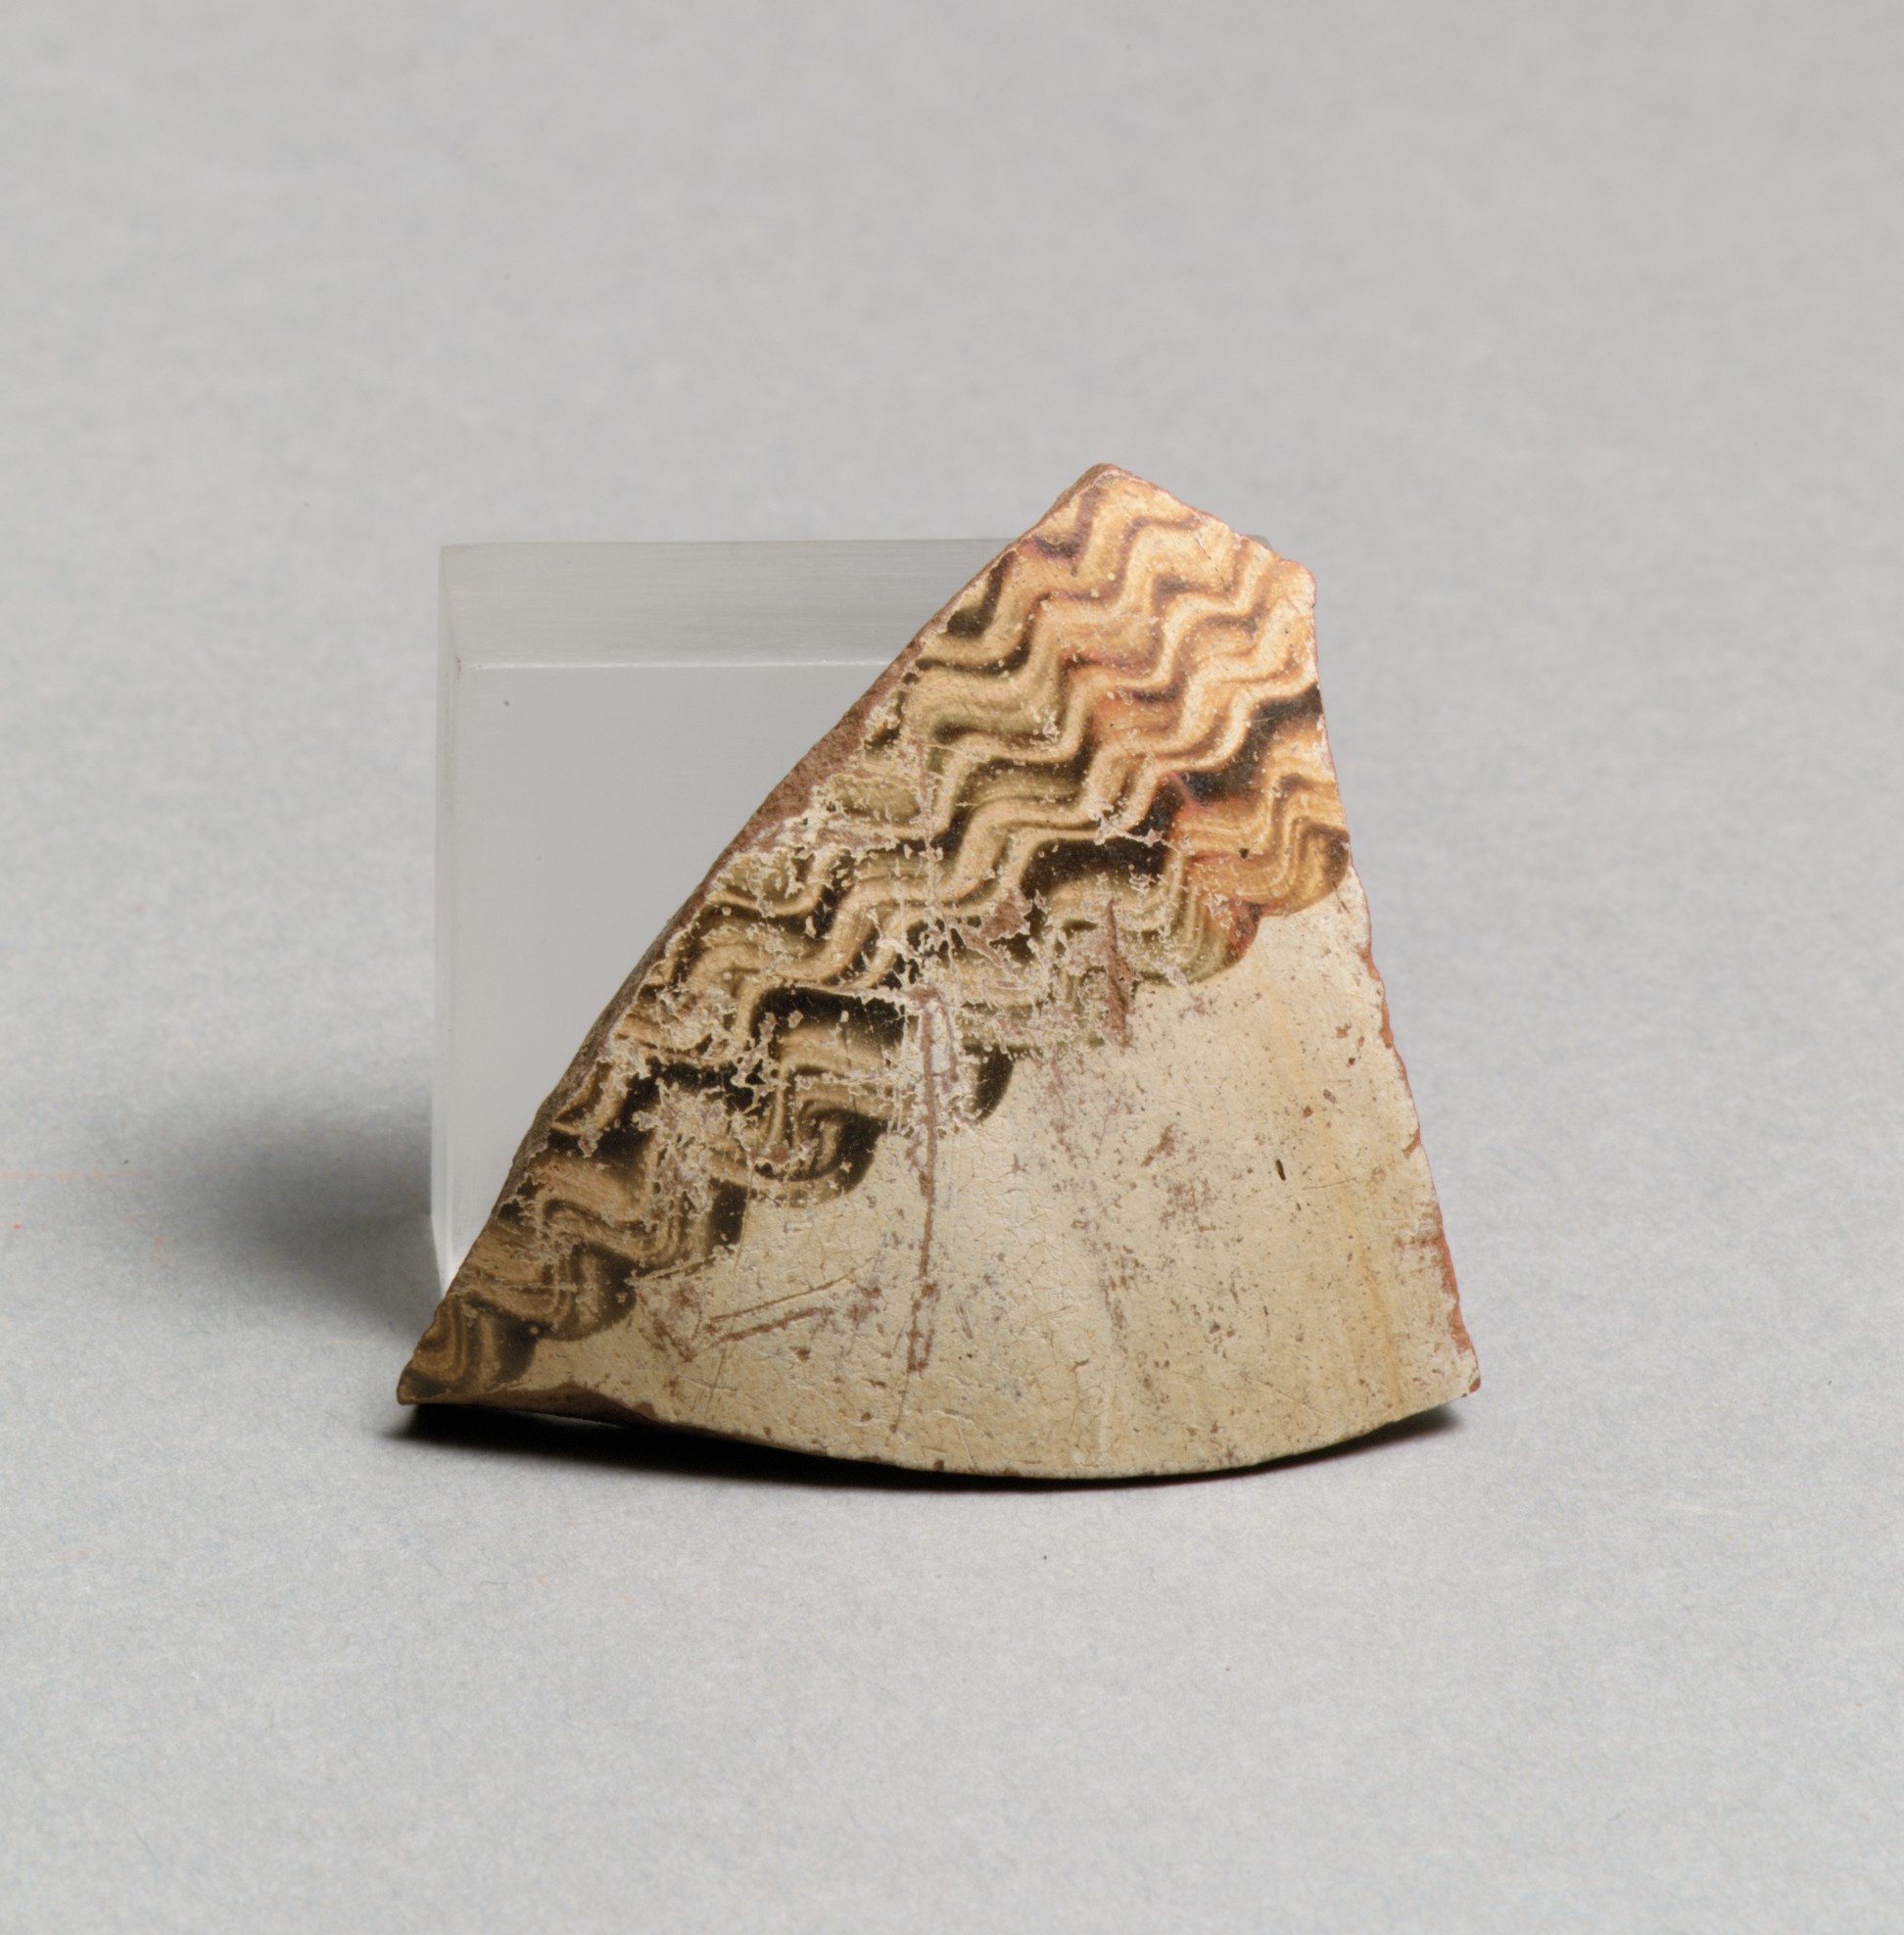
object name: vase fragment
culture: greek or lydian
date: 900-30 BCE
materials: terracotta